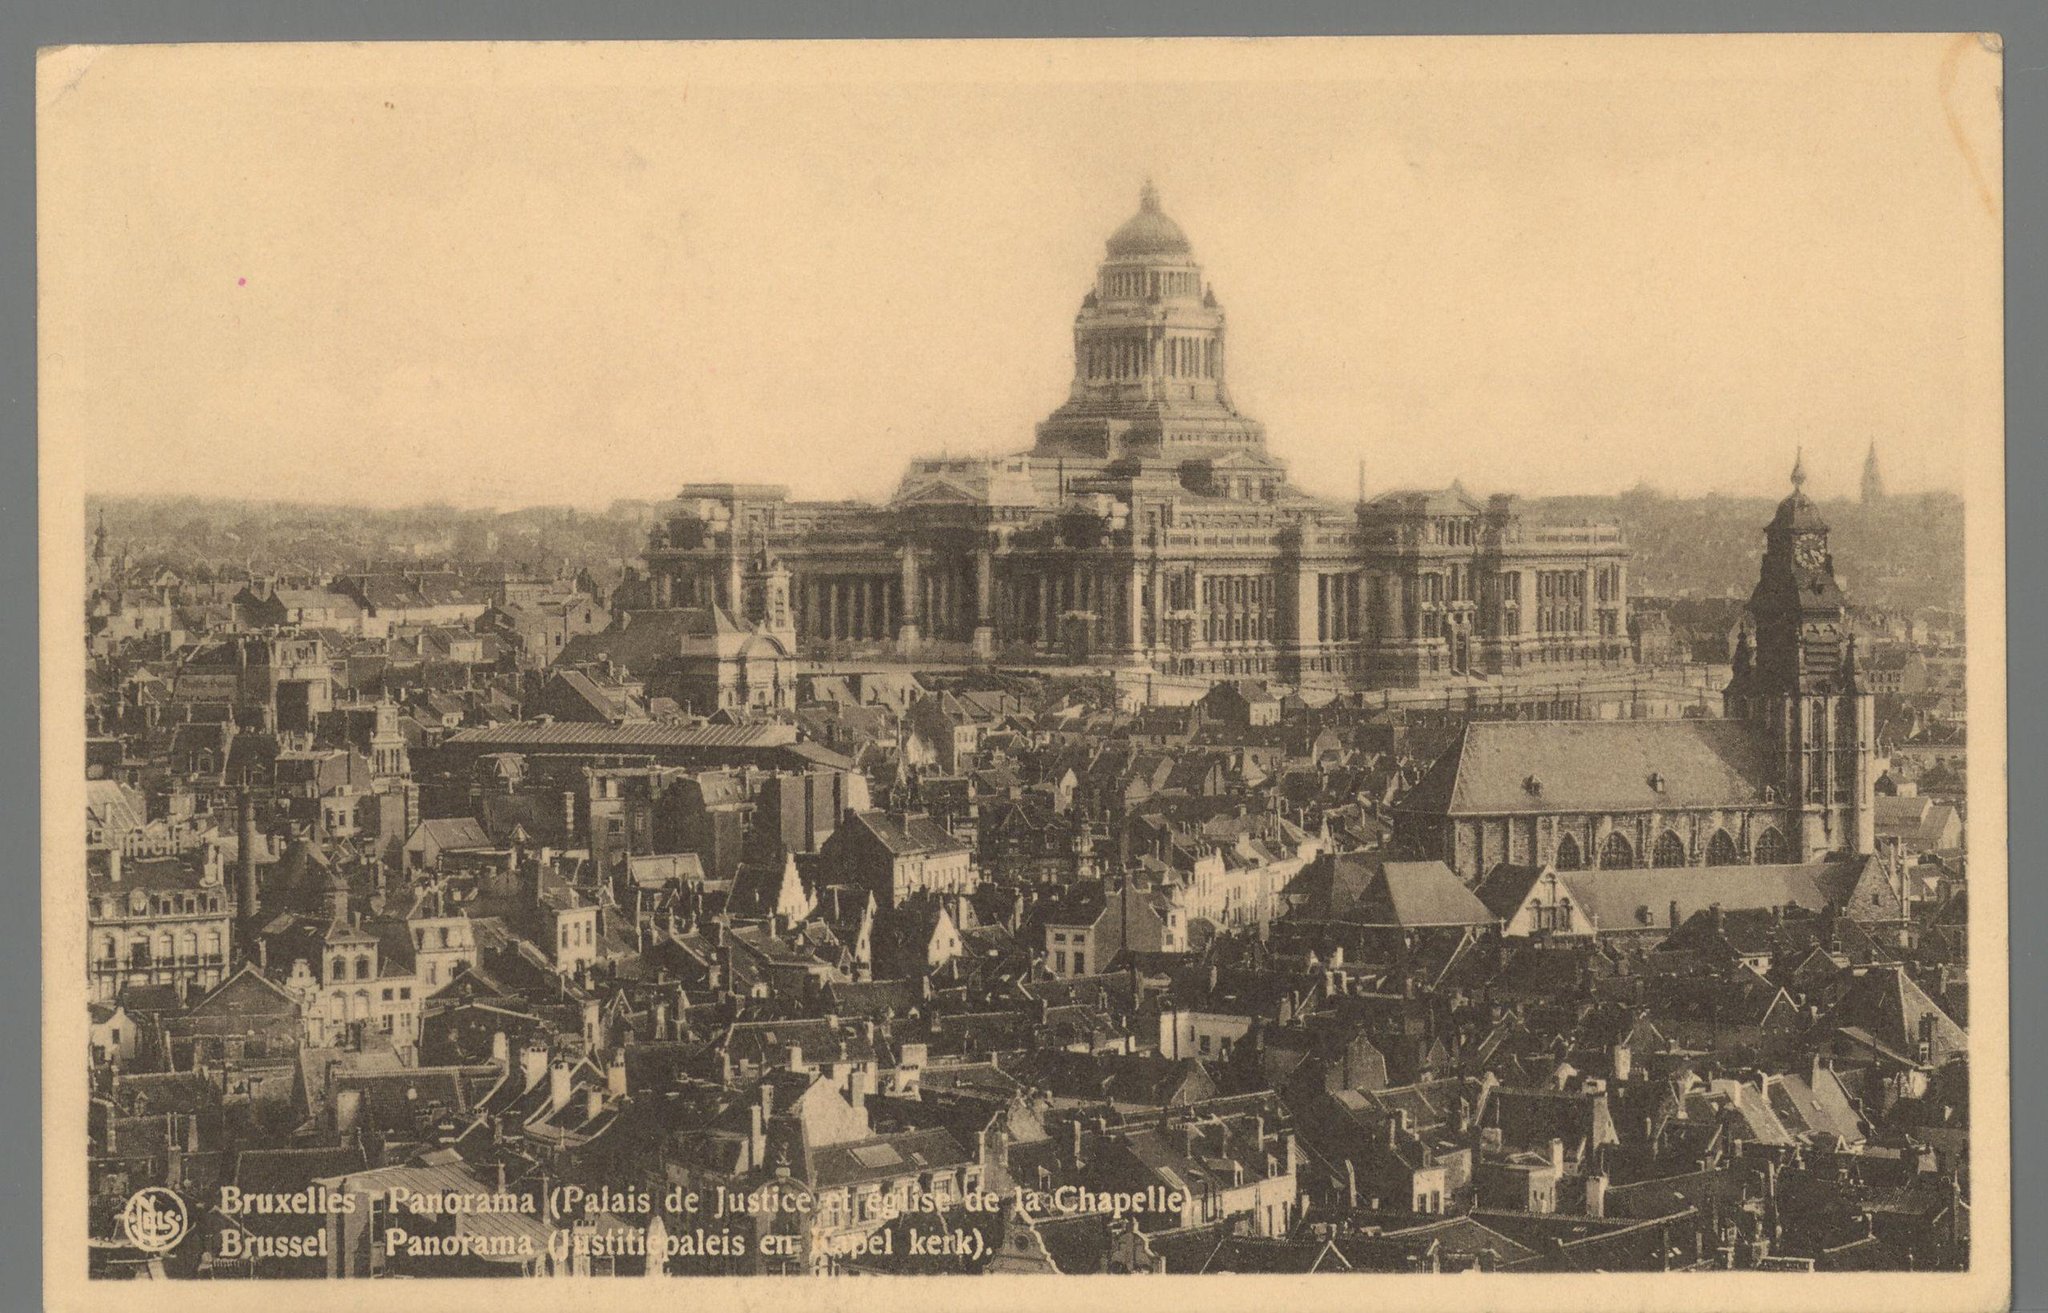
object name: photomechanical print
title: Bruxelles. Panorama (Palais de Justice et église de la Chapelle) / Brussel. Panorama (Justitiepaleis en Kapelkerk)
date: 1913-1930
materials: cardboard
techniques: photograph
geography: brussels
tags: court building, prospect of city, town panorama, silhouette of city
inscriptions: postage stamp